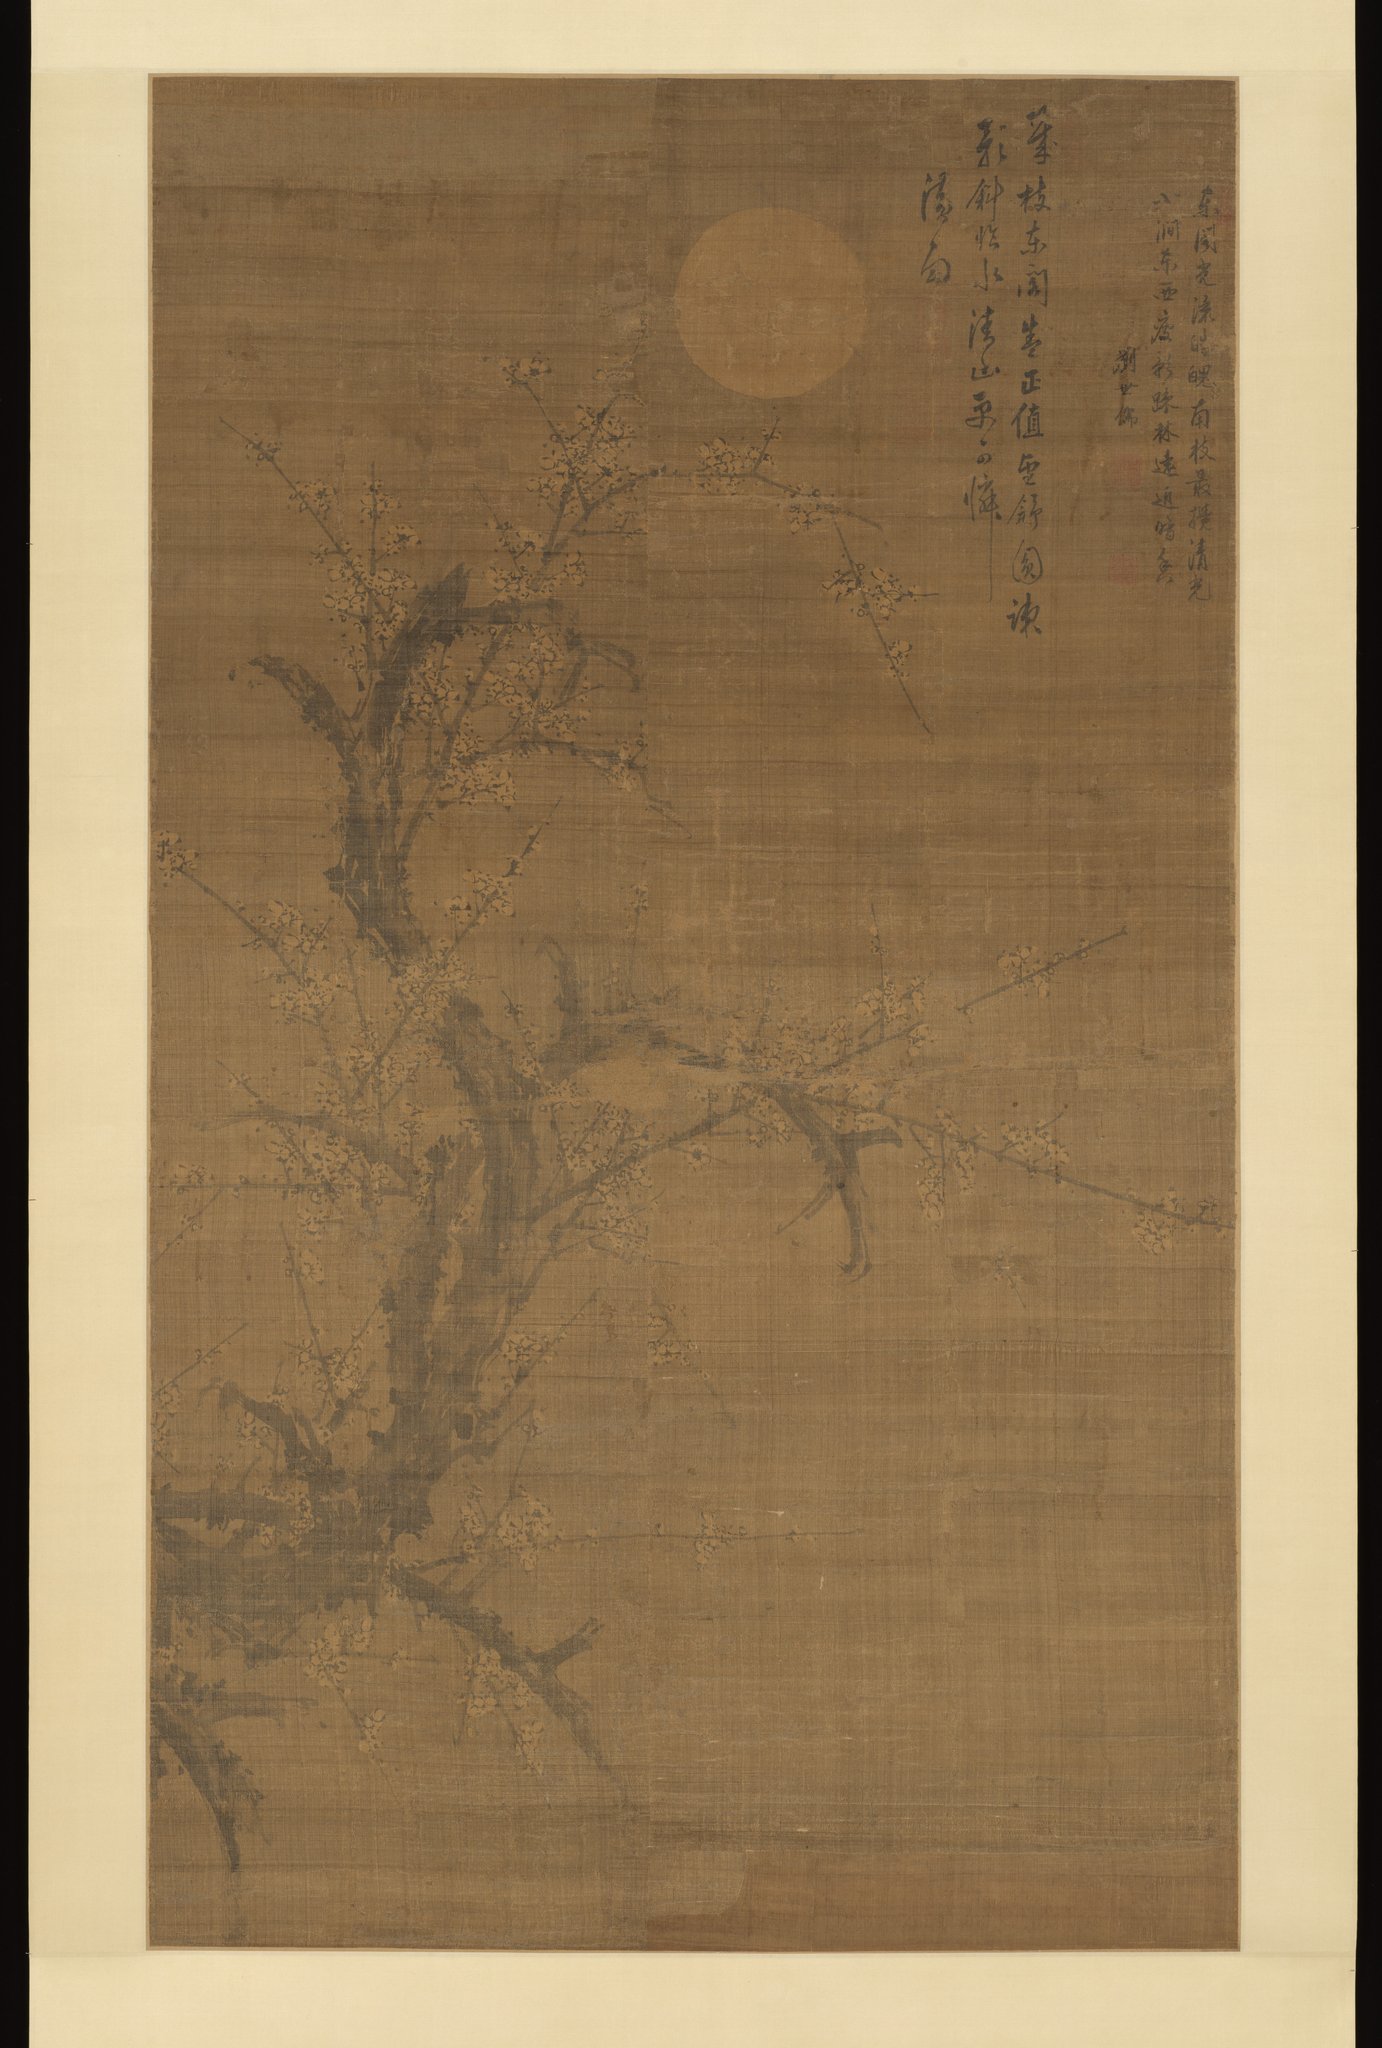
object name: hanging scroll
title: Flowering Plum in Moonlight and Snow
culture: chinese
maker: liu shiru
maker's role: artist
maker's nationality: chinese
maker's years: 1550-1600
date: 1501-1600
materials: ink, silk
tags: moon,trees